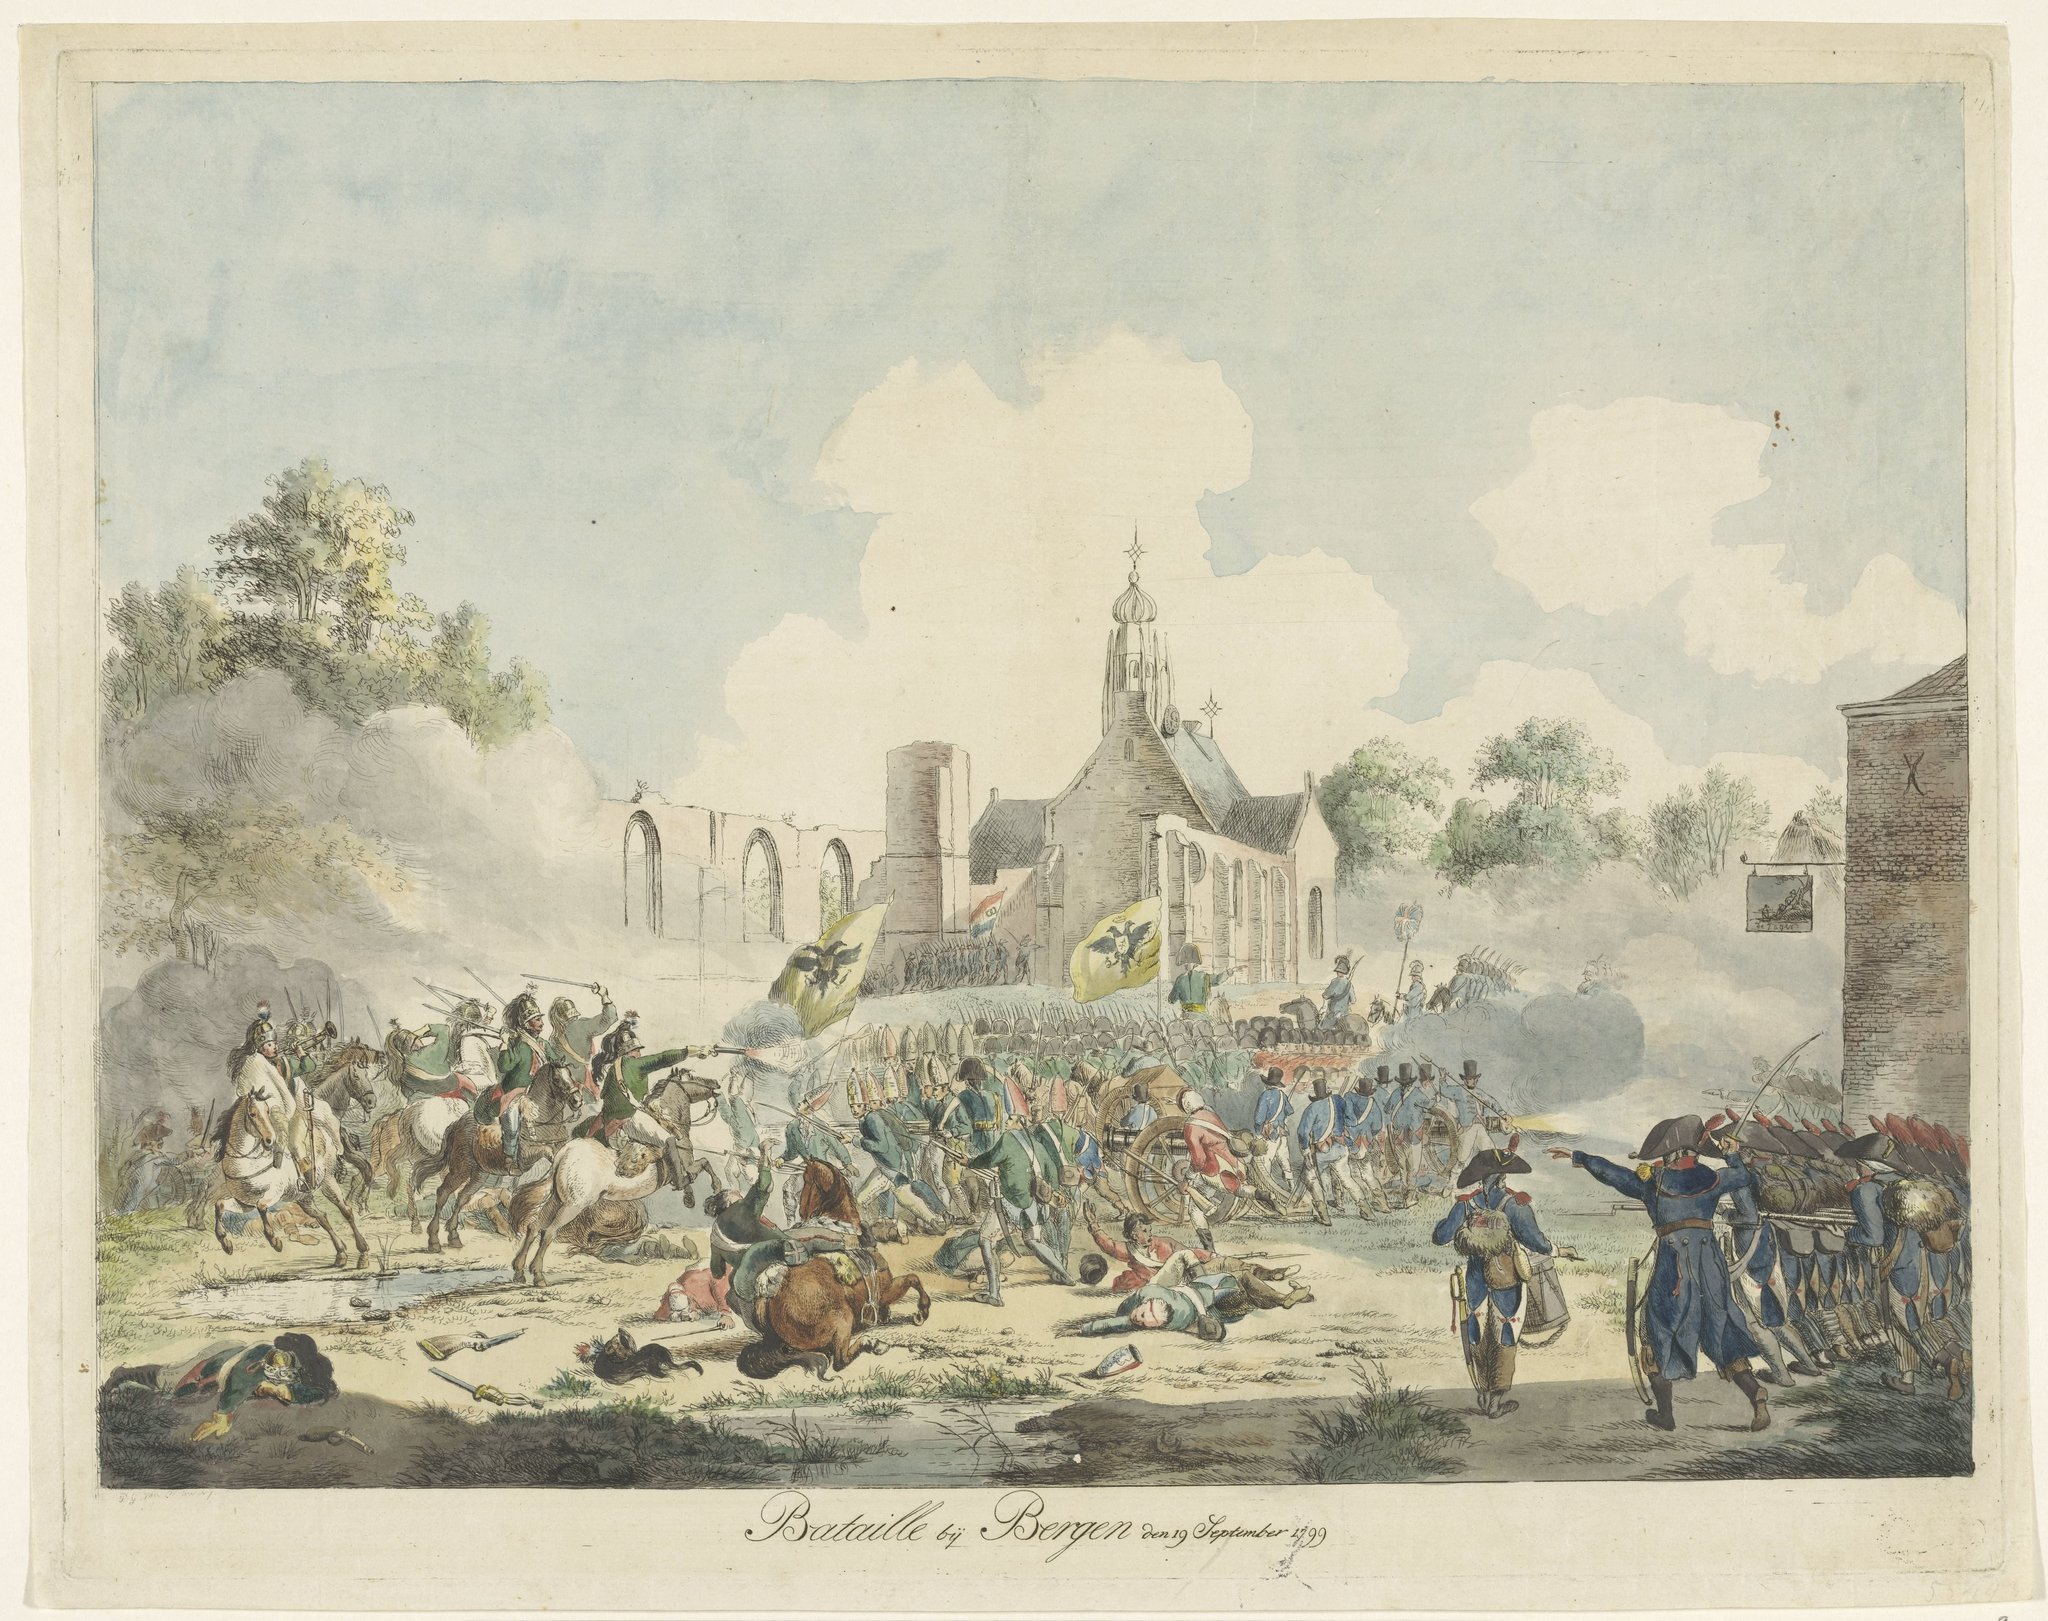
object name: print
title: Bataille bij Bergen den 19 September 1799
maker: pieter gerardus van os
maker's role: draughtsman, painter, print maker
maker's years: 1776-1839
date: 1799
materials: paper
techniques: engraving, etching, hand coloring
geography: netherlands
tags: battle (+ land forces)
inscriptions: collector's mark: Lugt 2228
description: De slag bij Bergen op 19 september 1799. Gezicht op het slagveld in het centrum van Bergen. Links Franse huzaren te paard, rechts Frans-Bataafse infanterie. In het midden Britse en Russische troepen voor de Ruïnekerk. Rechts de herberg 'de Jager'.